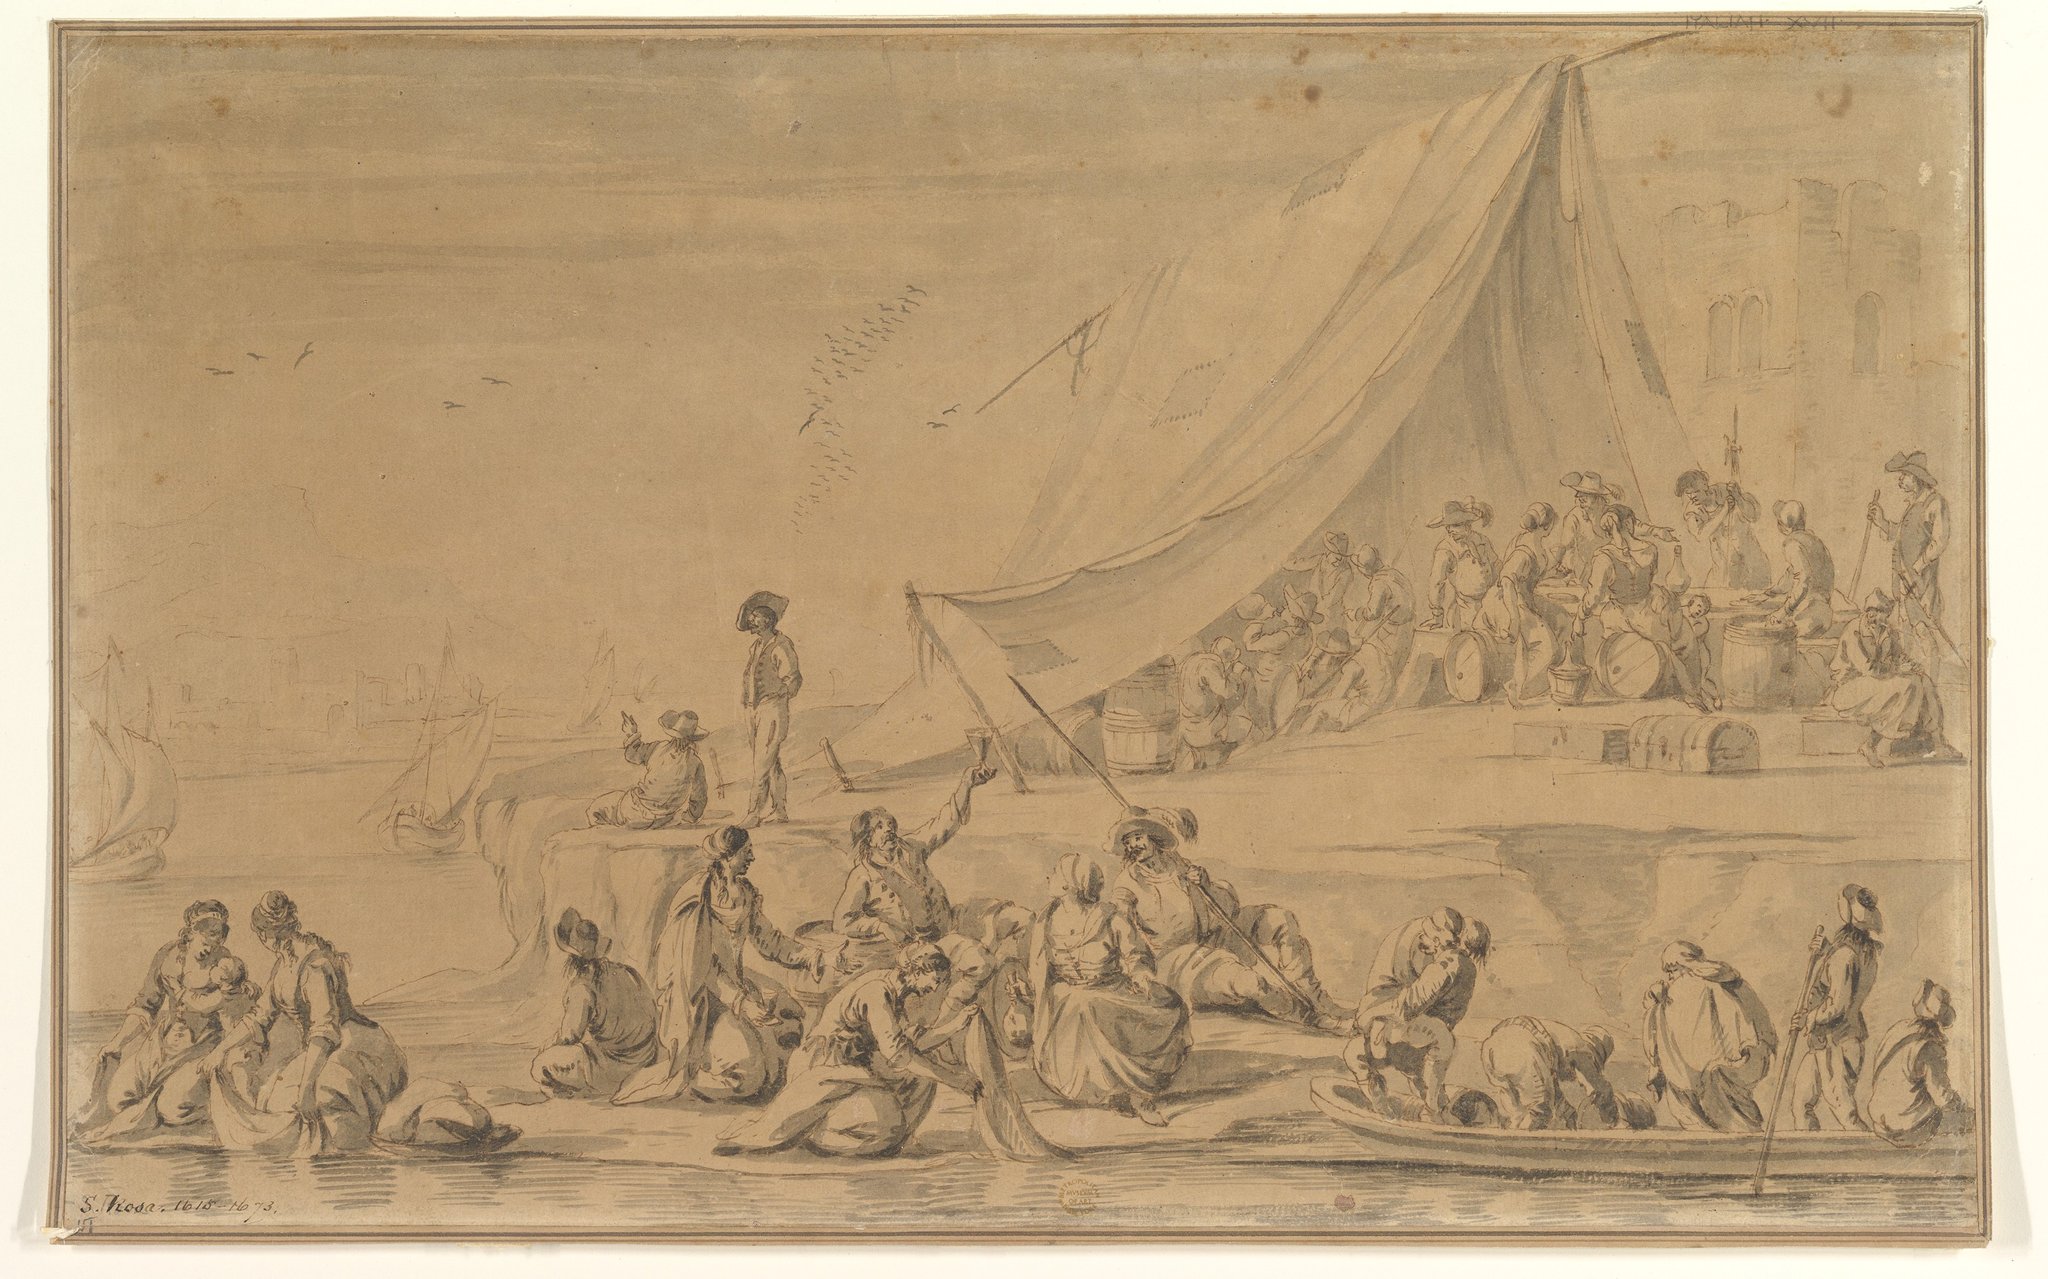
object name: drawing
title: A Pirate's Camp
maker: anonymous, italian, 17th century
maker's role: artist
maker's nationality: italian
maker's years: 1600-1700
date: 1601-1700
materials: ink, paper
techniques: brush, pen, wash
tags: tents,men,women,boats